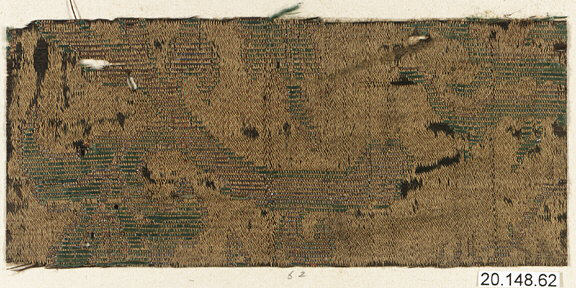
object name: piece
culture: japanese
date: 1401-1500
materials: silk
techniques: compound weave